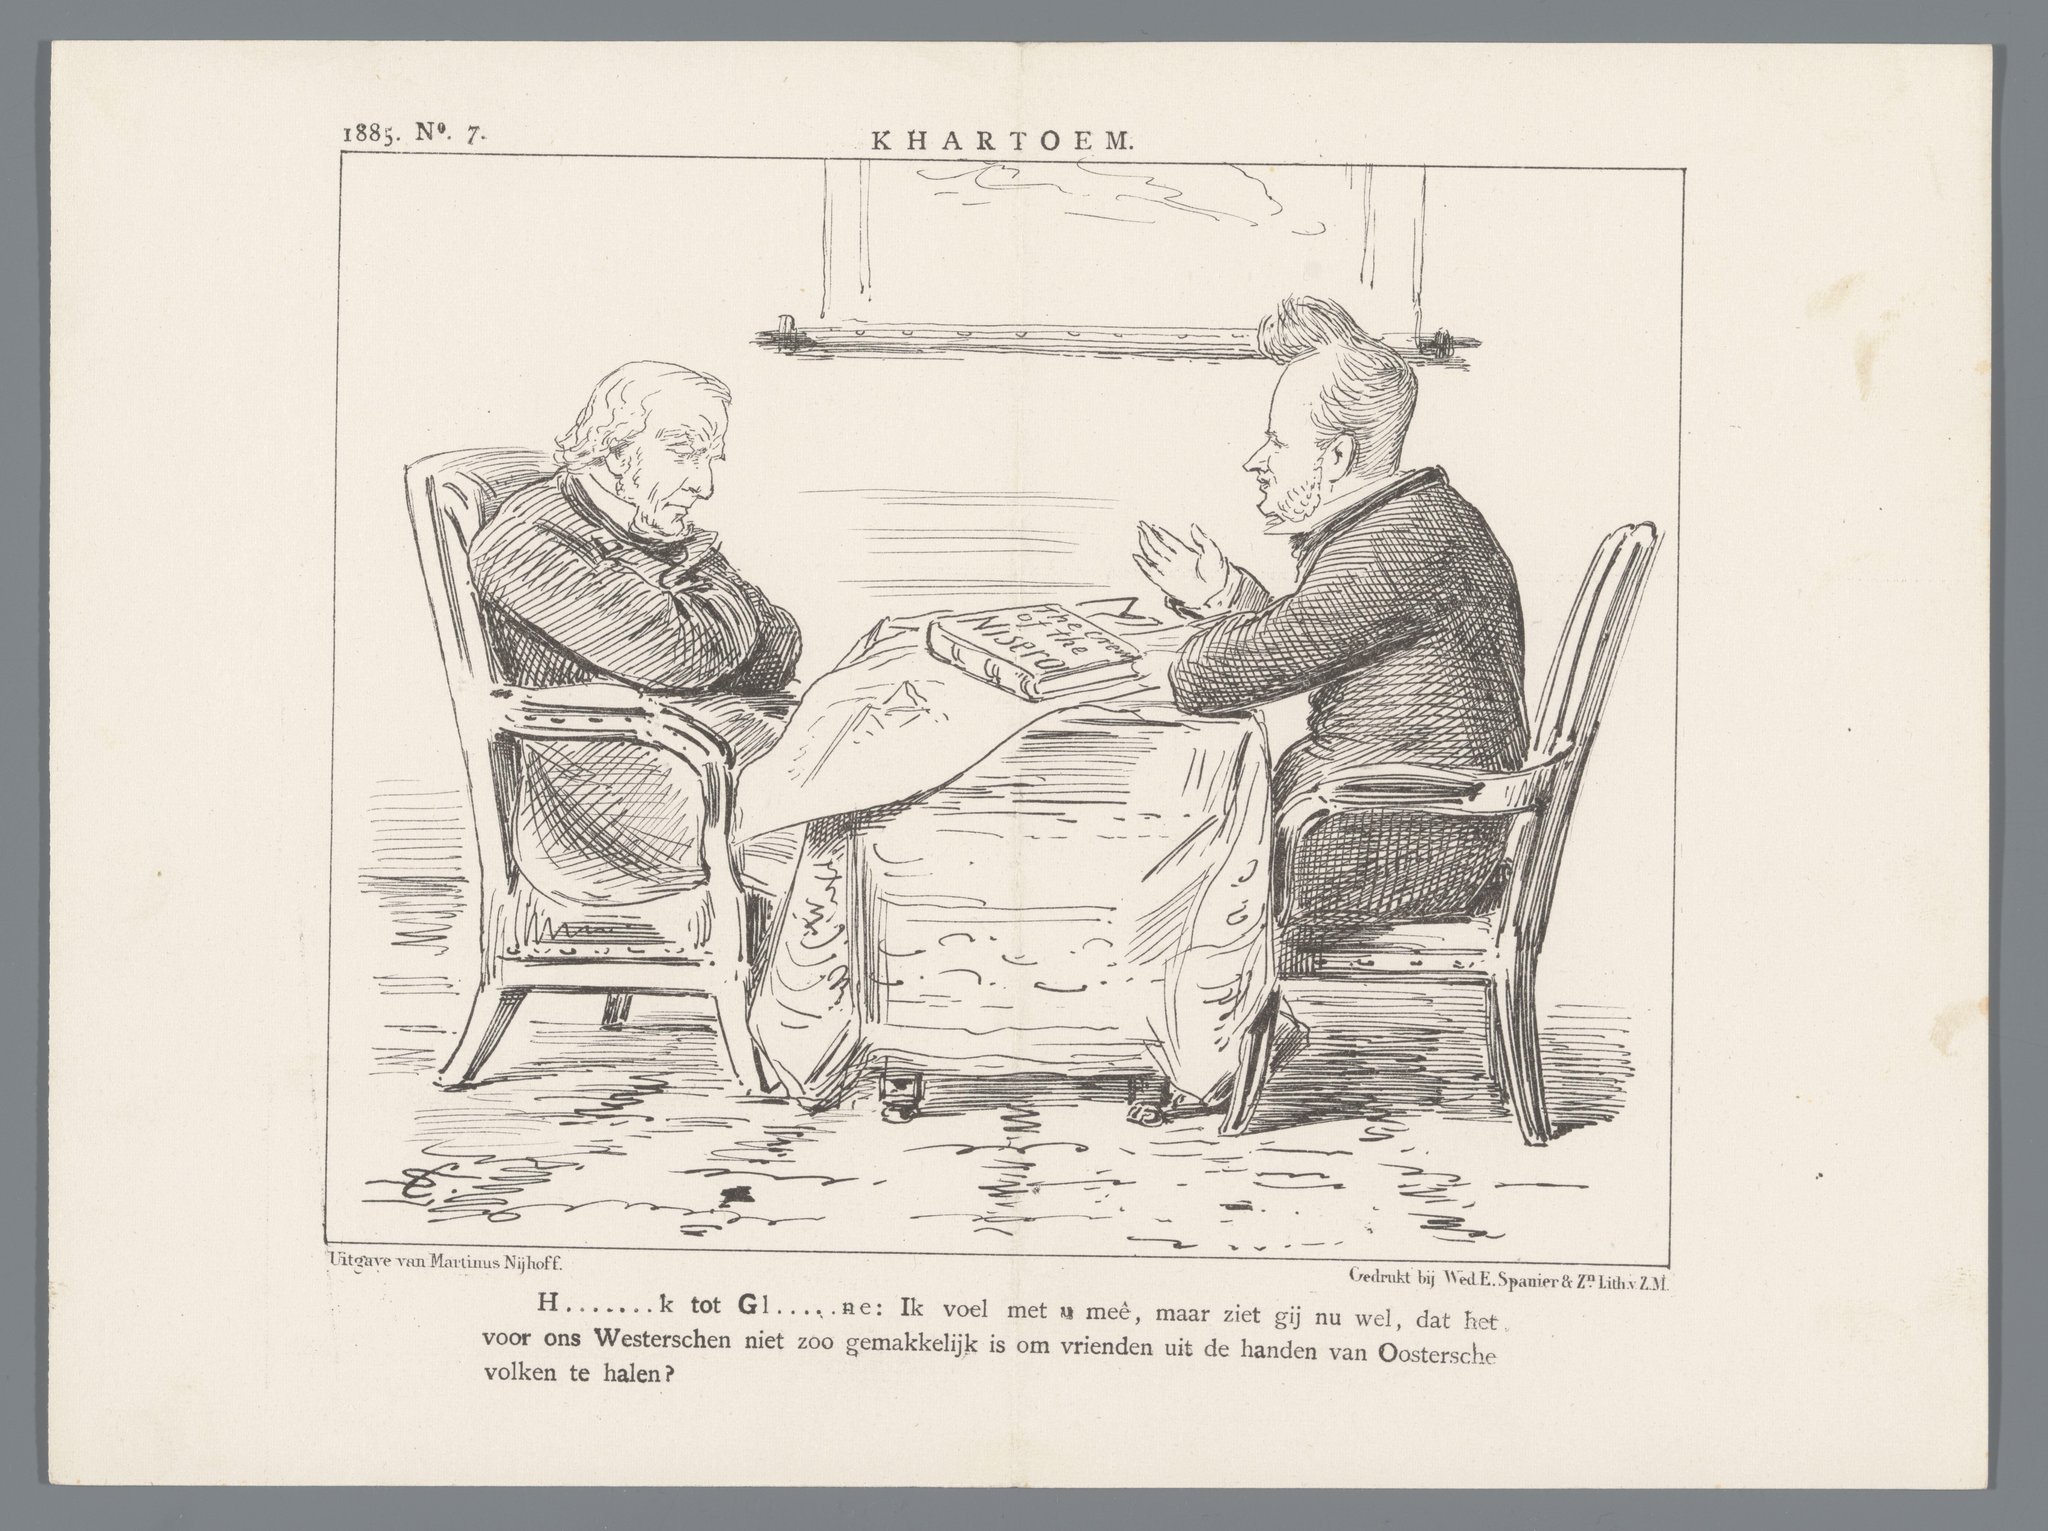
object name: cartoon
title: Spotprent op Heemskerk en Gladstone, 1885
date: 1885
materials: paper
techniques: lithograph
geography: netherlands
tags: the hague, liverpool, politician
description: Spotprent op minister Heemskerk en de Britse premier Gladstone en de belegering van Khartoem. Plaat verschenen bij het weekblad De Nederlandsche Spectator, nr. 7, 1885.